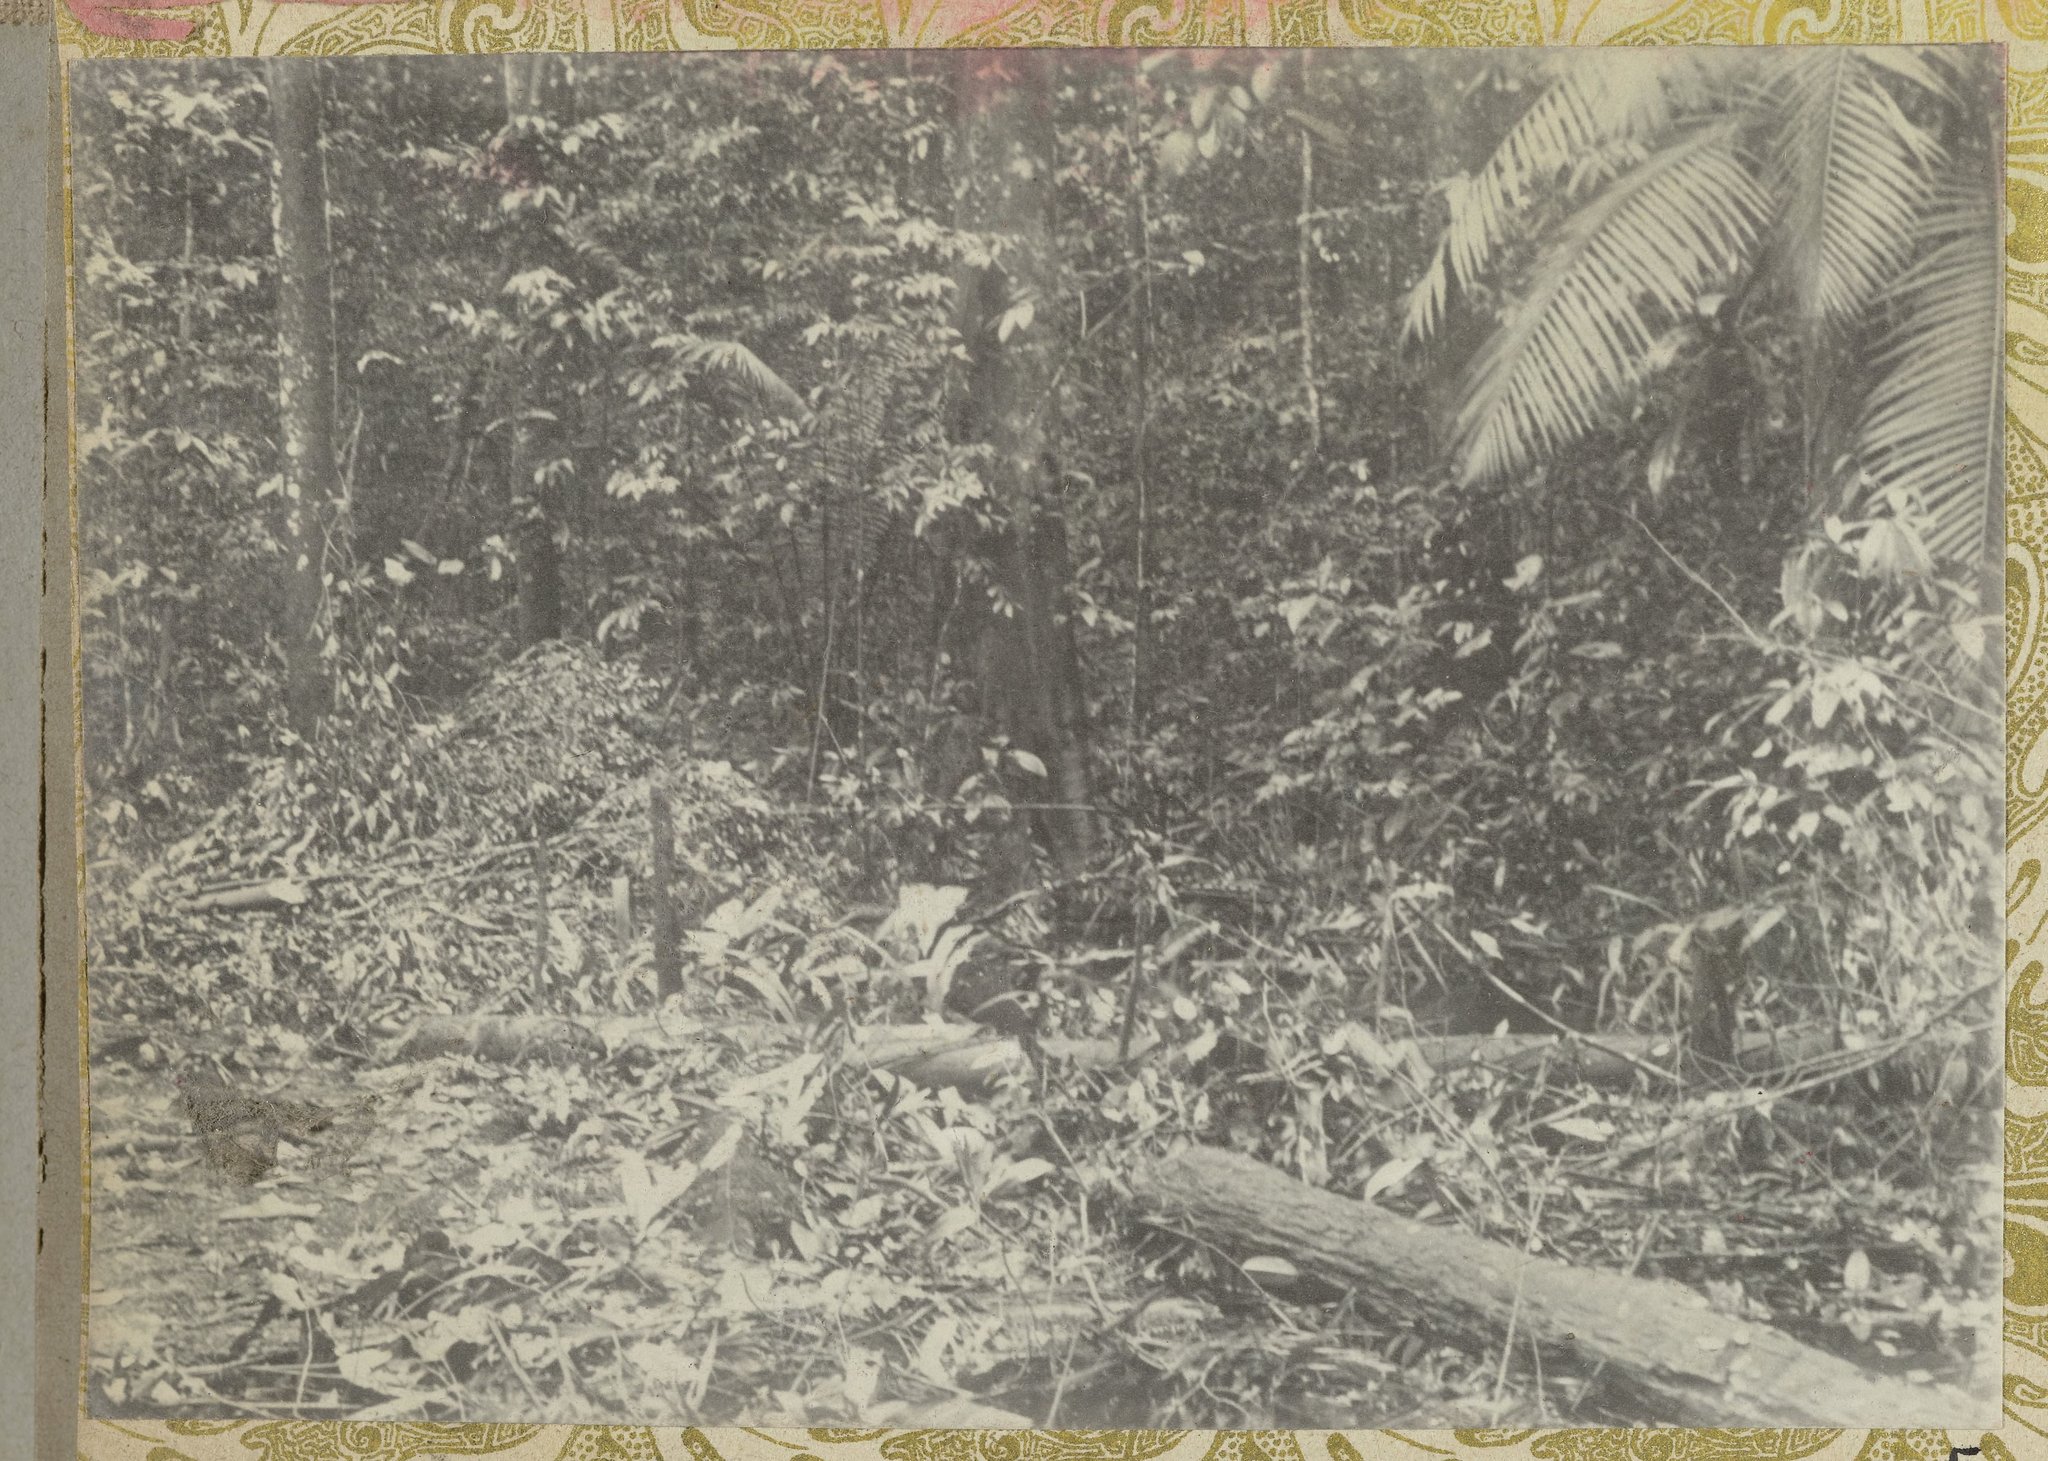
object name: photograph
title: In het oerbosch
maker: hendrik doijer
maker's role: engineer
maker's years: 1863-1925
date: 1903-1910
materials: photographic support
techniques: gelatin silver print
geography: suriname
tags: suriname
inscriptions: inscription: ‘5’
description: Bomen en planten in het Surinaamse oerbos. Onderdeel van het fotoalbum Souvenir de Voyage (deel 1), over het leven van de familie Doijer in en rond de plantage Ma Retraite in Suriname in de jaren 1903-1910.